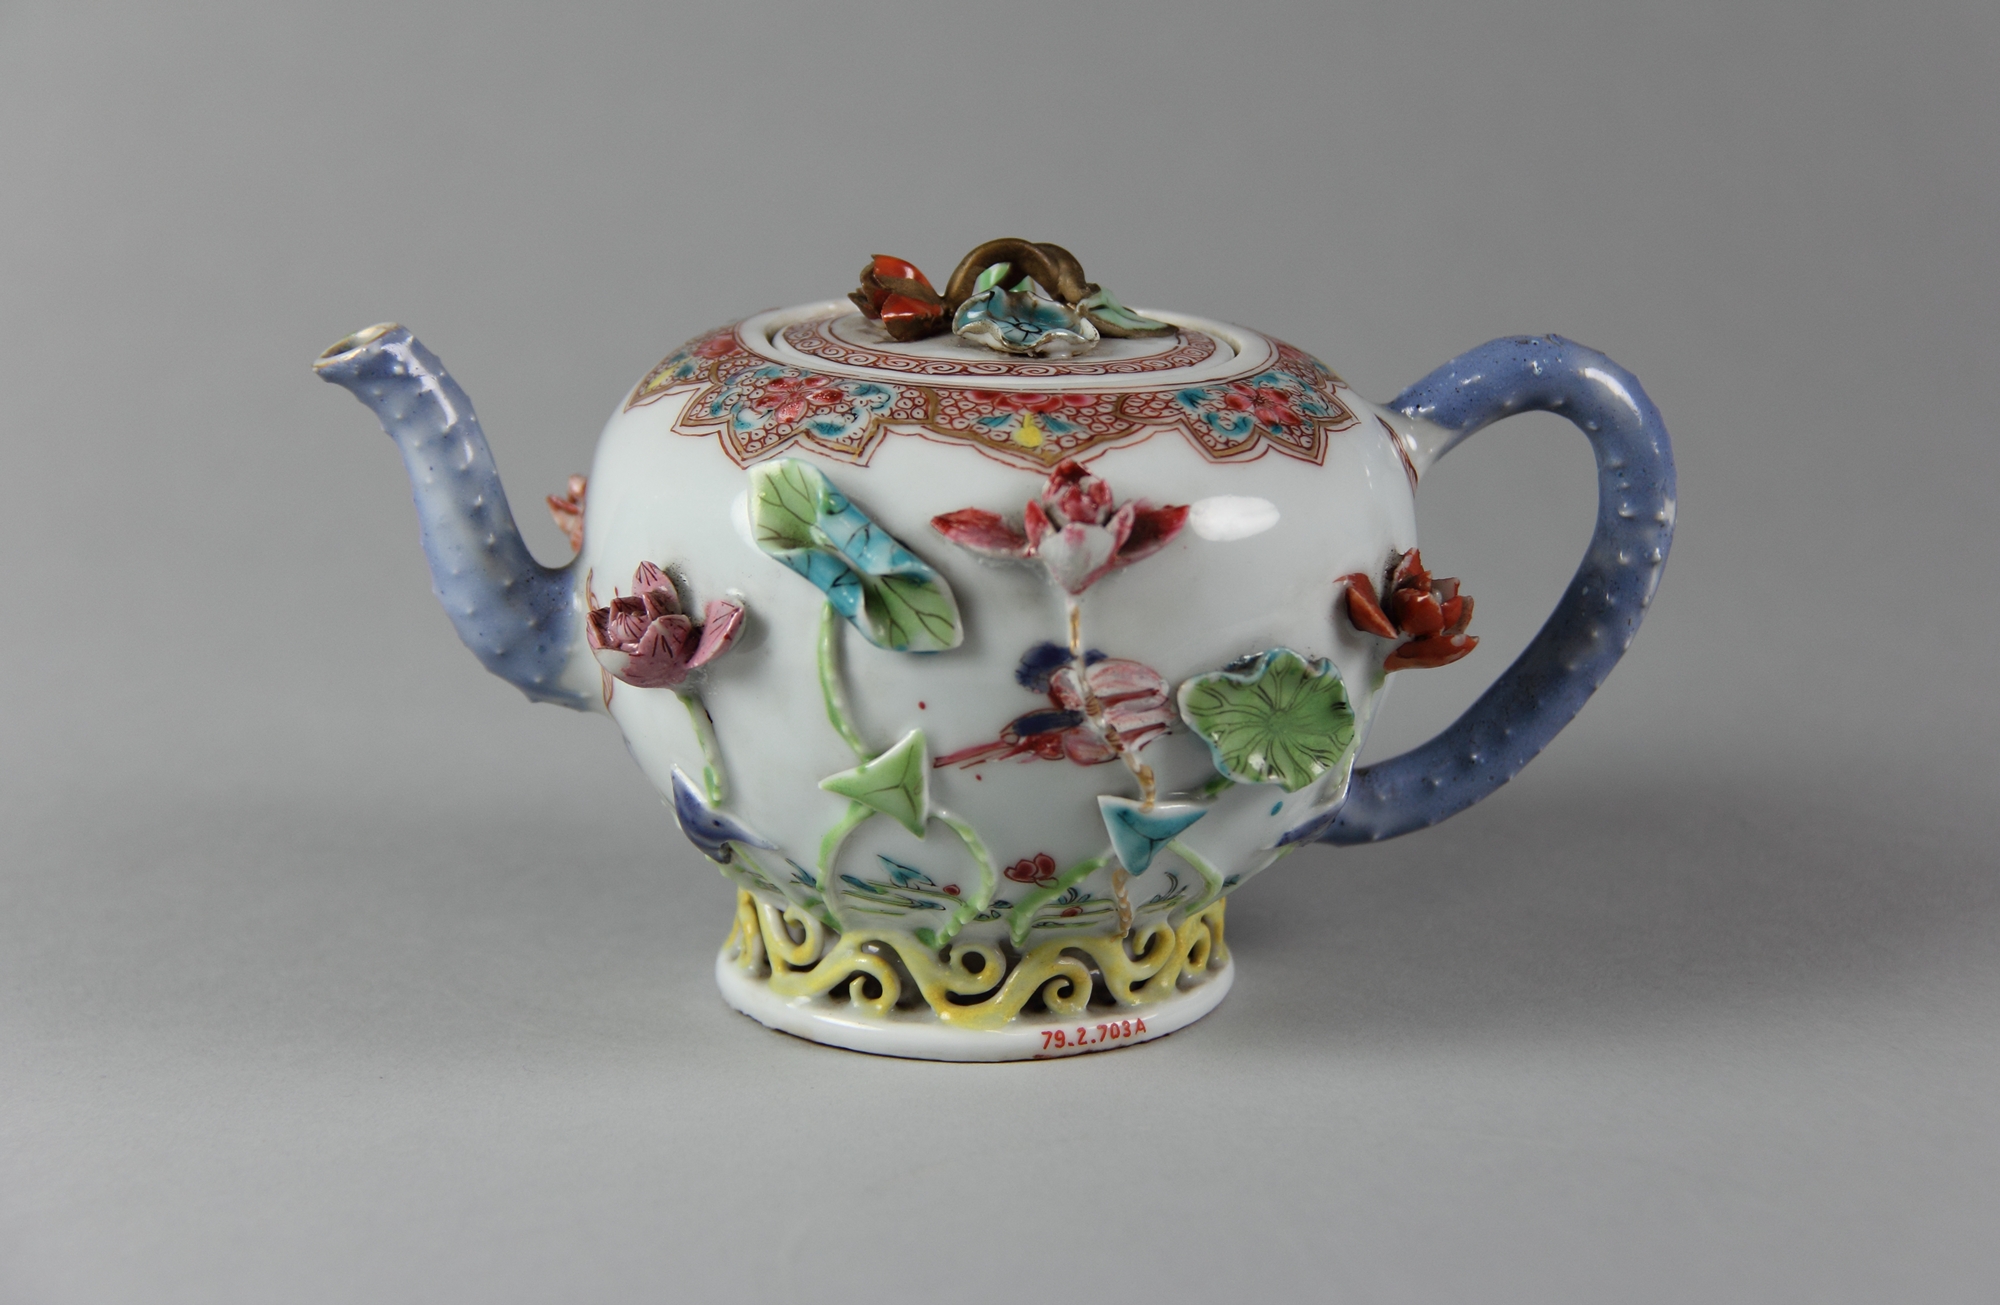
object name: teapot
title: Teapot with lotus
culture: chinese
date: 1767-1800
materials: enamel, porcelain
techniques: overglaze, painting, polychrome, relief